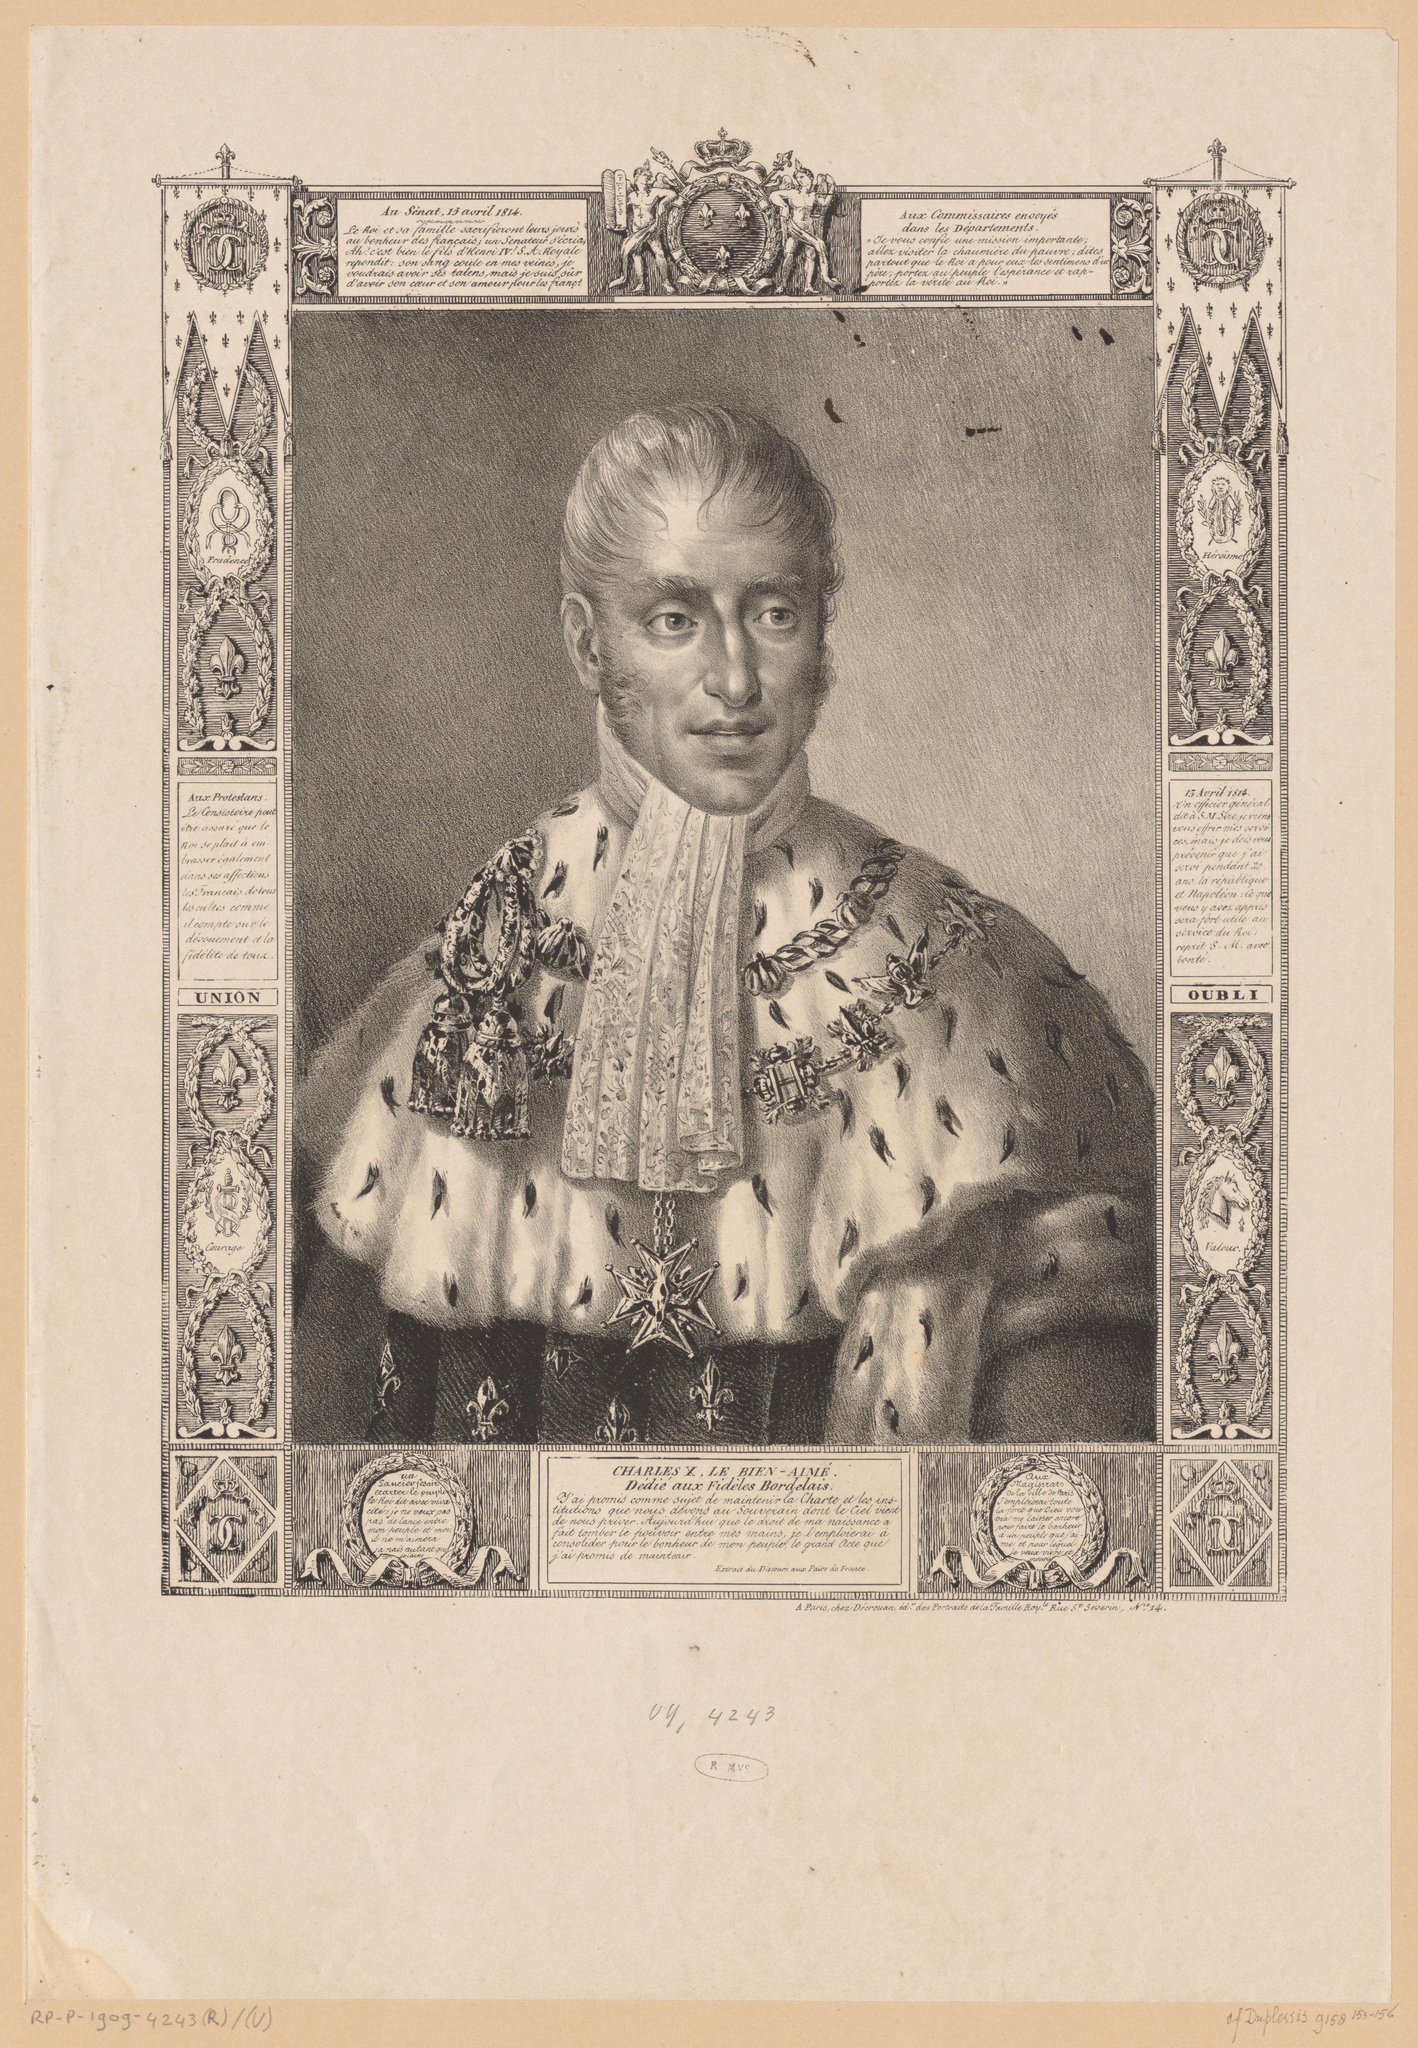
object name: print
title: Portret van Karel X, koning van Frankrijk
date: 1822-1835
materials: paper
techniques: lithograph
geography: paris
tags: historical persons, king, armorial bearing, heraldry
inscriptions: collector's mark: Lugt 2228